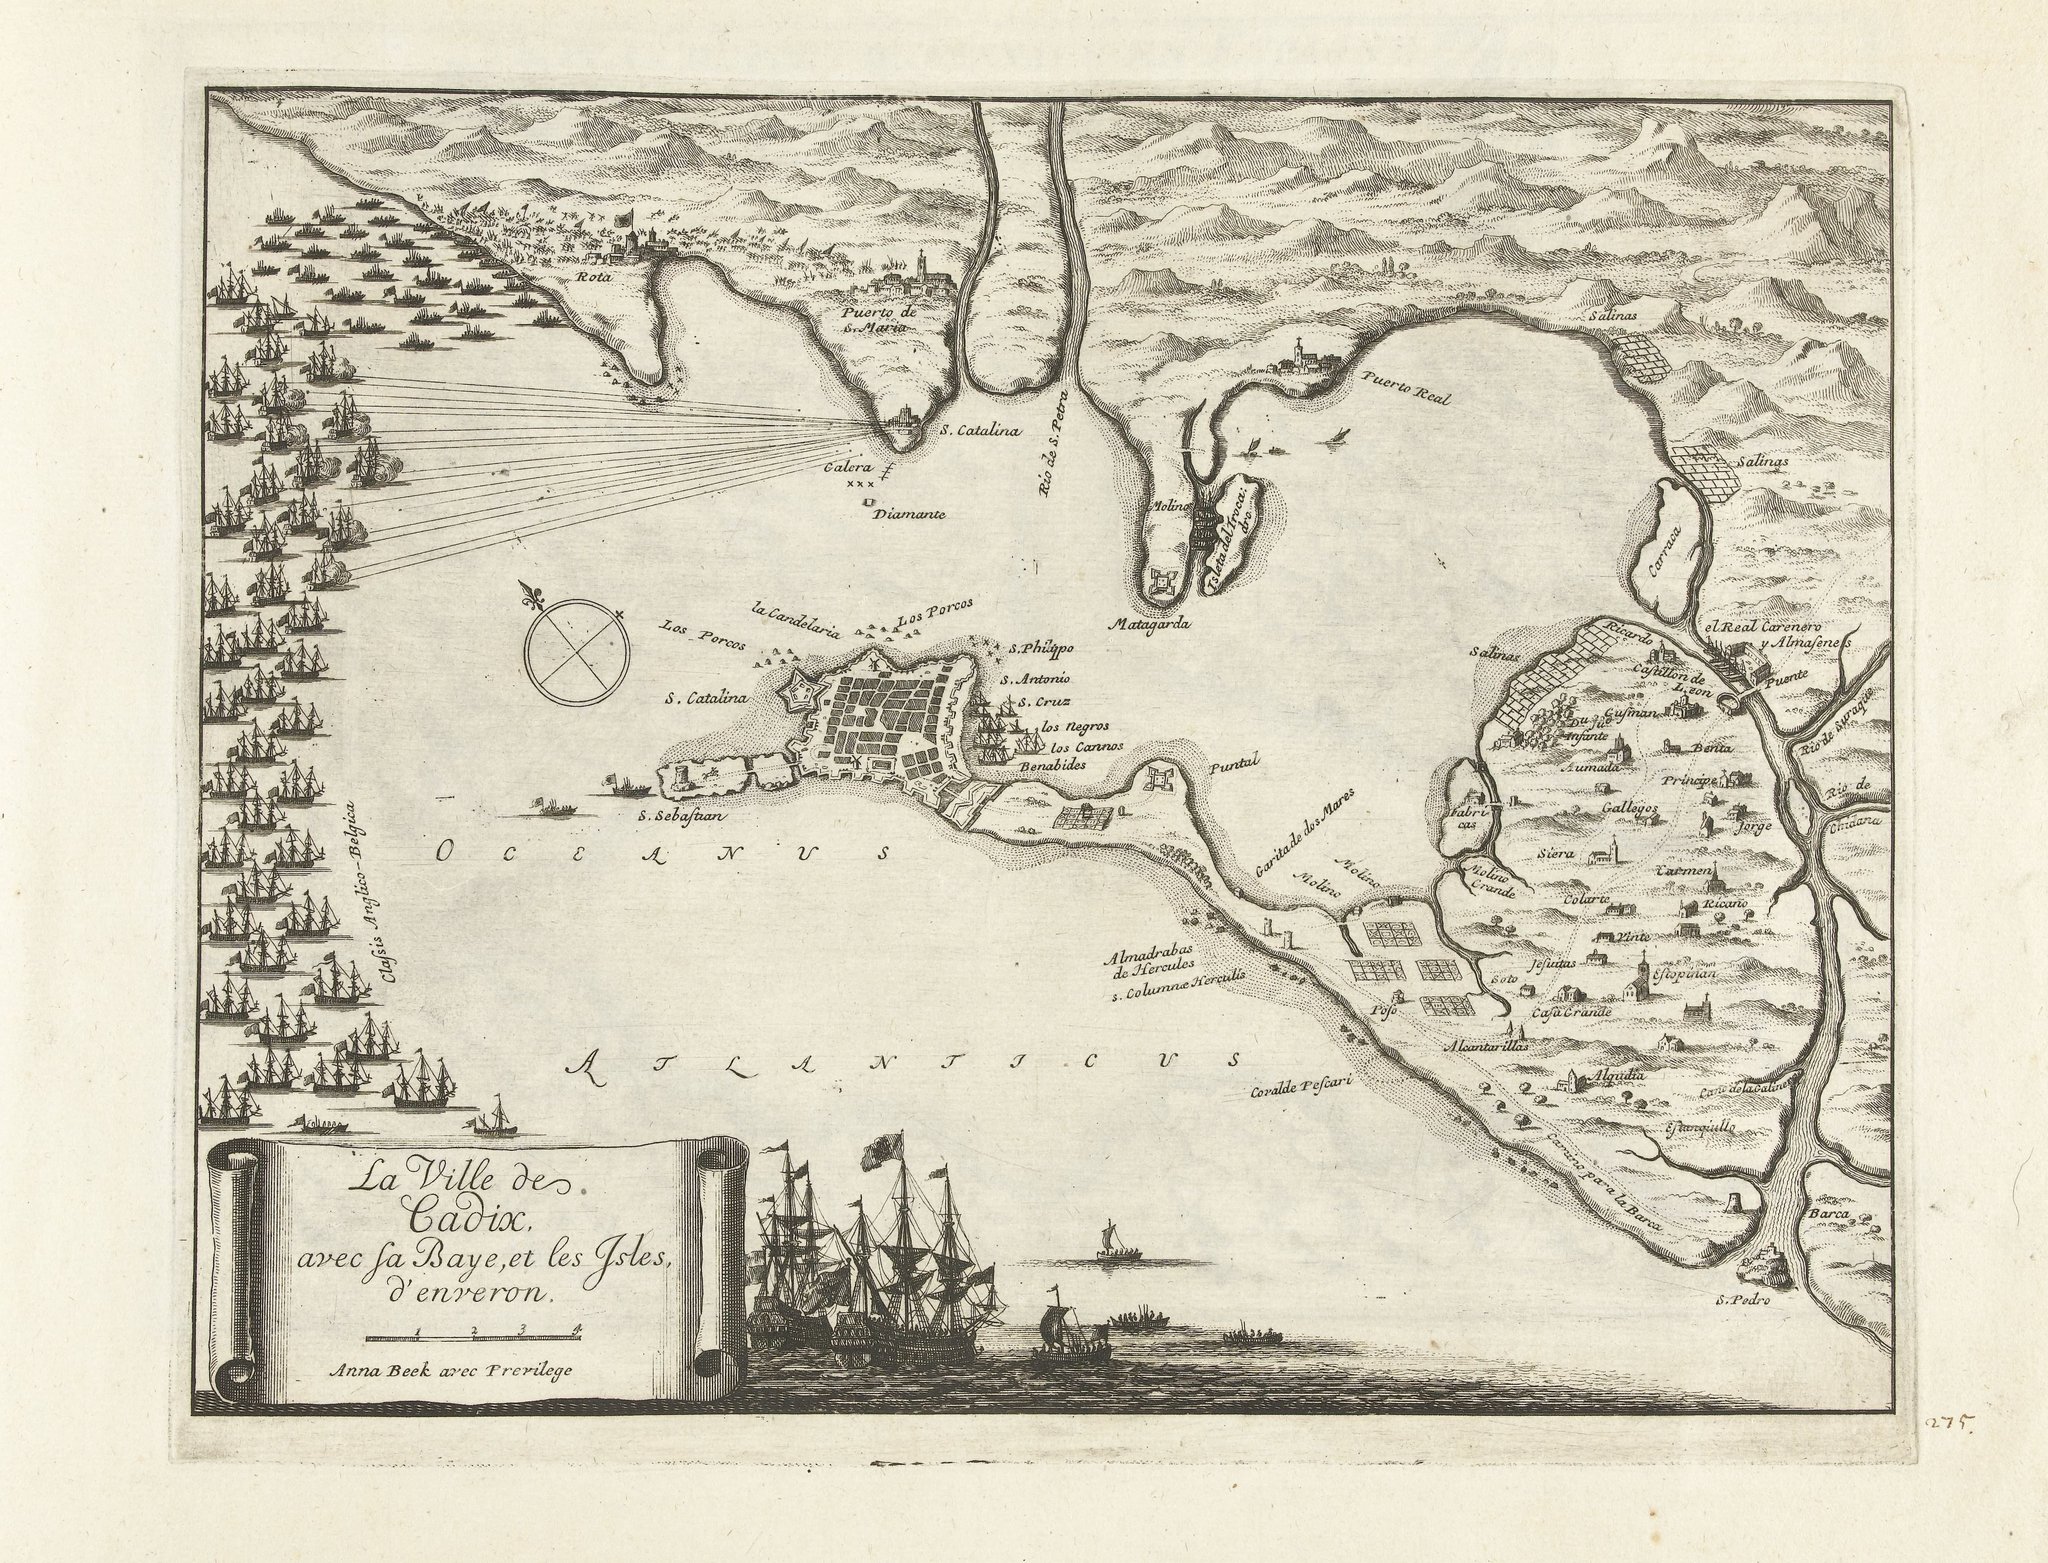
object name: print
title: Kaart met de strijd om Cadiz, 1702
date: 1702-1703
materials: paper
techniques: etching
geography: northern netherlands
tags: maps of separate countries or regions, battle (+ land forces)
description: Kaart van de kust bij Cadiz. Een Engels-Nederlandse vloot wordt door de Spanjaarden beschoten, bovenaan gaan troepen bij Rota aan land, 26 augustus 1702. Plaat nr. 275 in het prentwerk bestaande in totaal uit 276 genummerde platen van vermaarde sterke steden en vestingen in het kader van de Spaanse Successieoorlog. Voor het merendeel zijn deze platen gekopieerd naar de anonieme Franse platen: in Les forces de l'Europe en in: Le theatre de la guerre, dans les Pays-Bas, beide oorspronkelijk uitgegeven door Nicolas de Fer te Parijs (1693-1697) in het kader van de Negenjarige Oorlog. Titel en opschriften in de plaat in het Frans.